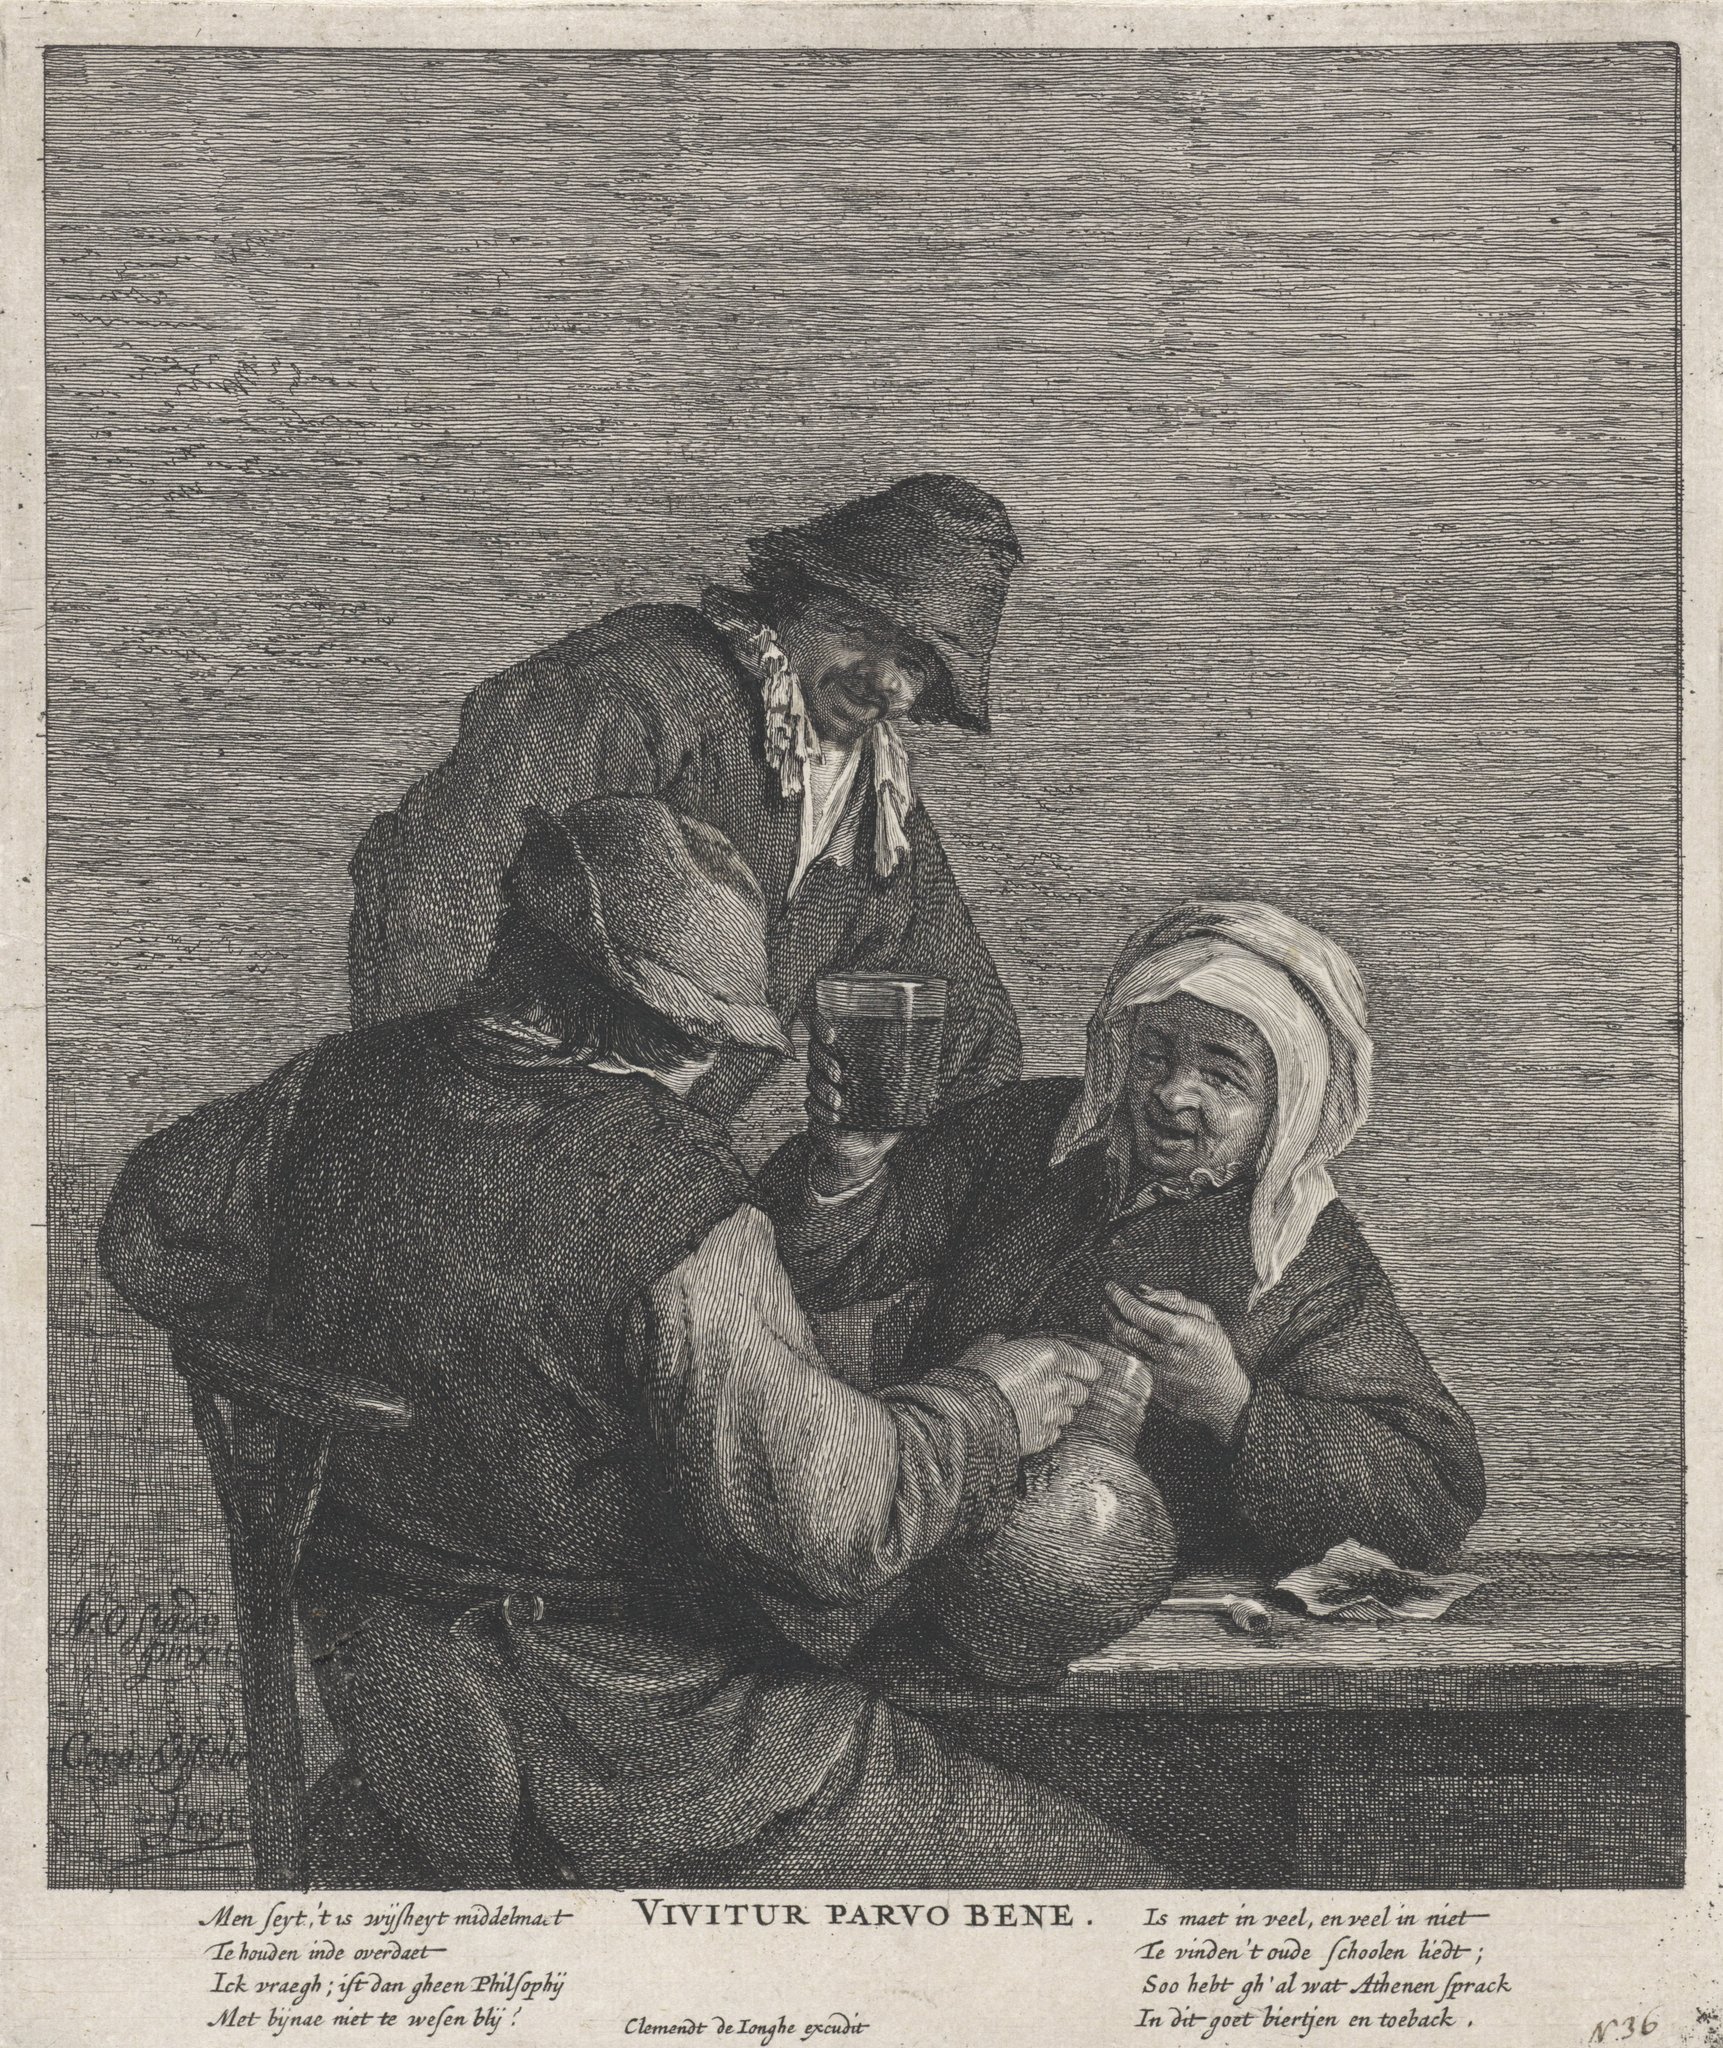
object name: print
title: VIVITUR PARVO BENE.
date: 1638-1670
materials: paper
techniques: engraving, etching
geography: amsterdam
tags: pipe ~ tobacco, drinking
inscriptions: collector's mark: Lugt 240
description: Drie drinkers bij een tafel. Een van hen heft het glas, een andere, op de rug gezien, houdt een bierkan in de hand. Op de tafel liggen een pijp en tabak.